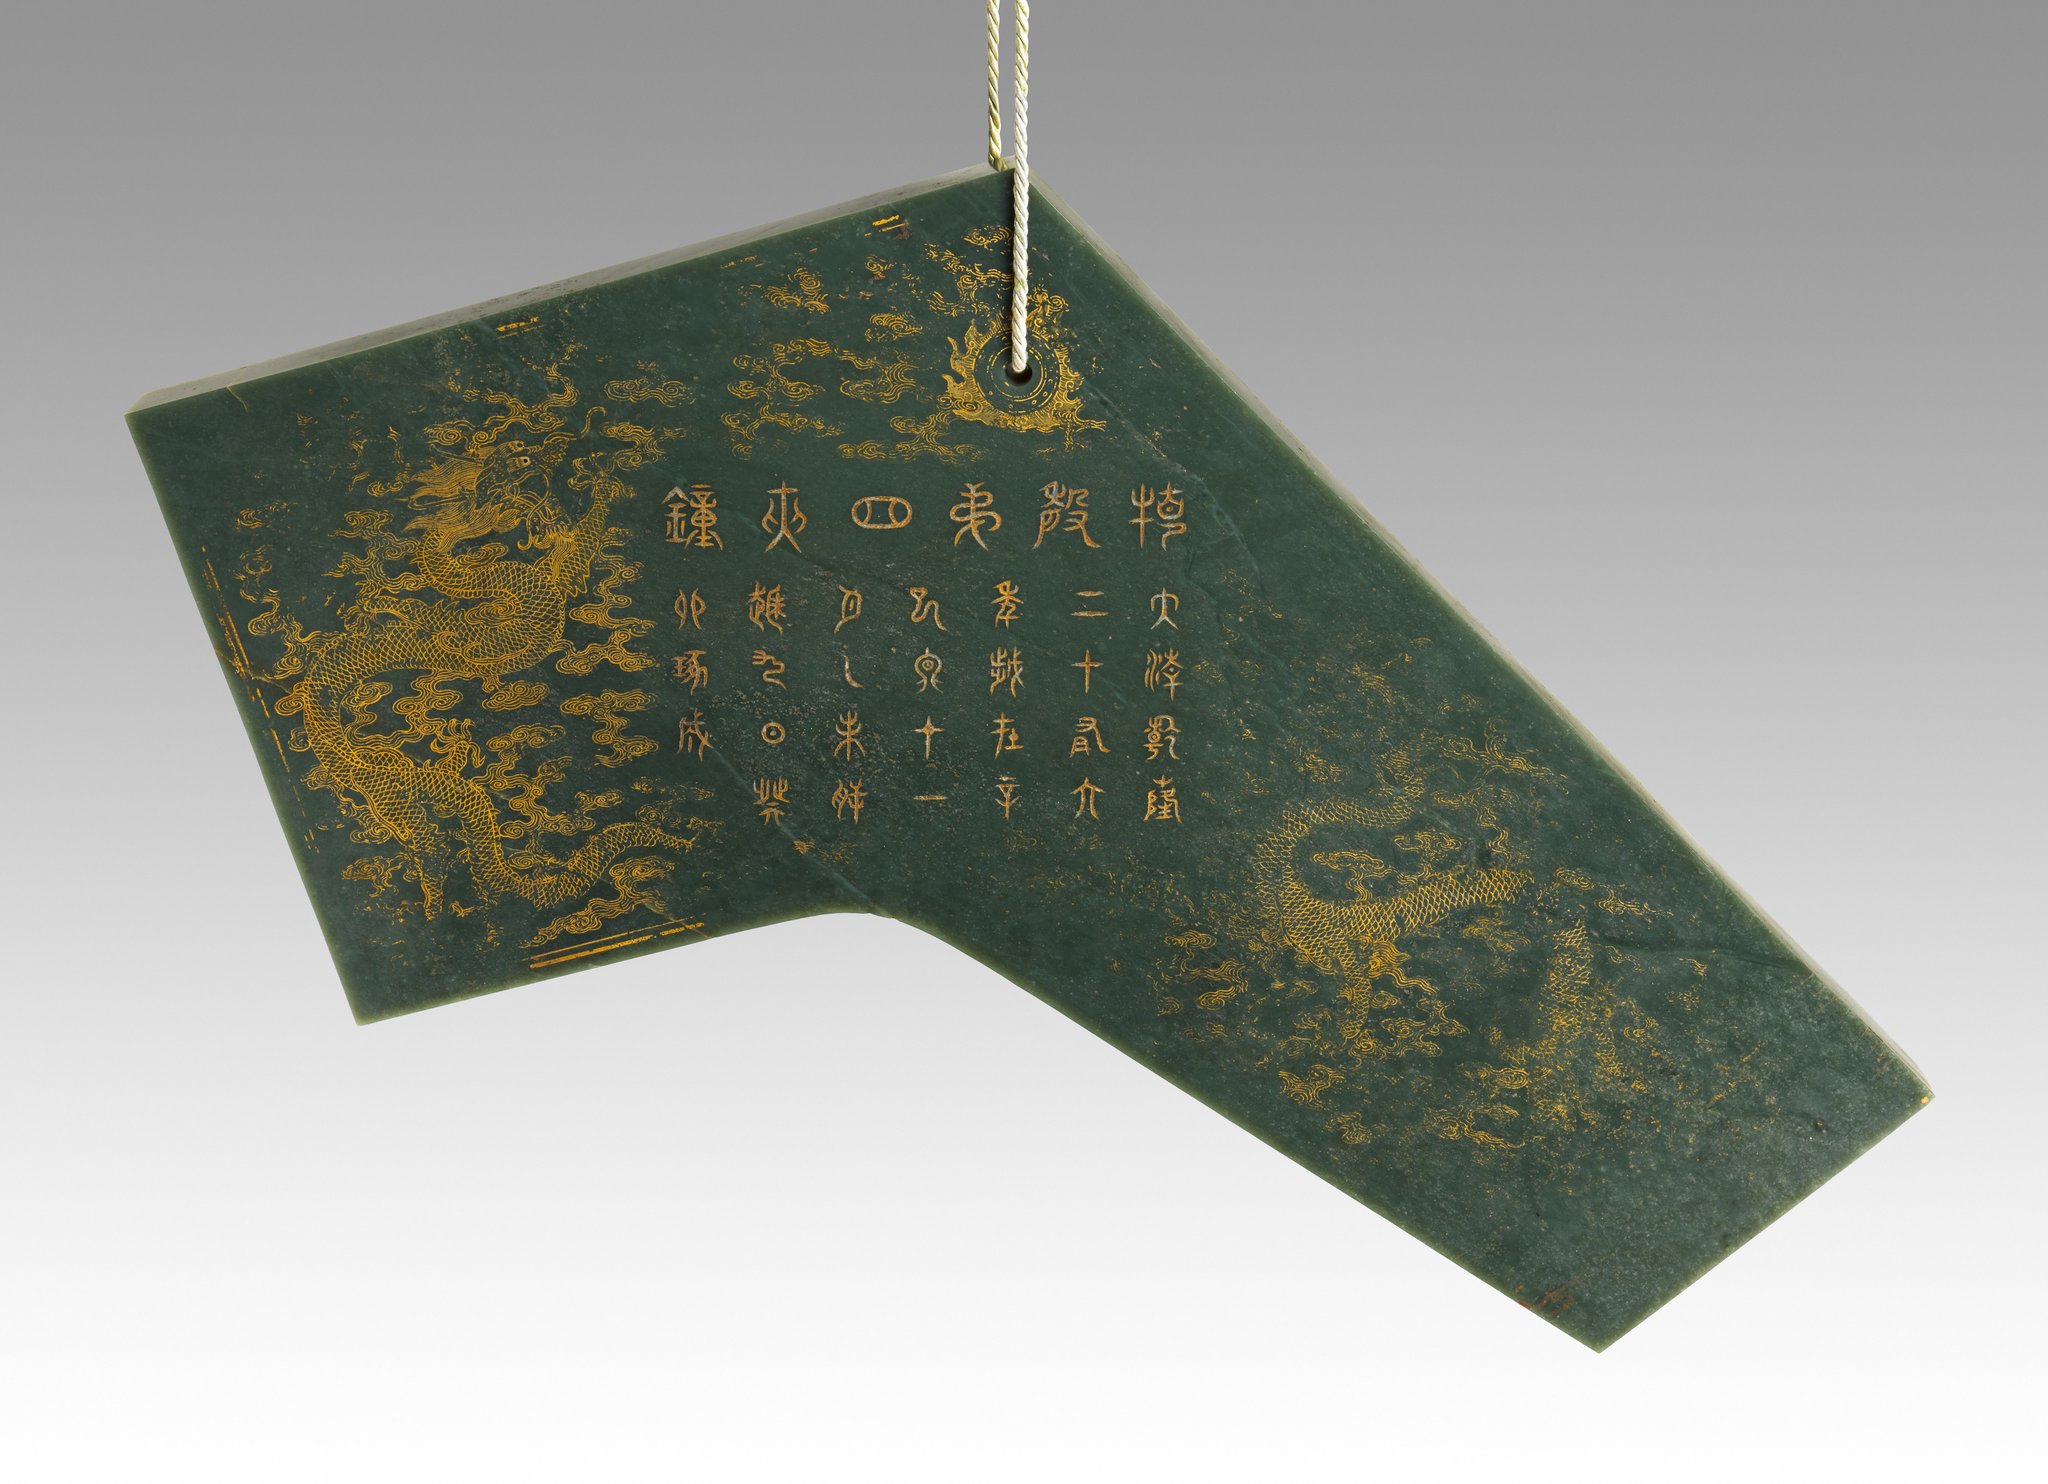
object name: chime qing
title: Qing (磬 )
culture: chinese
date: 1734-1766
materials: jade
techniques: gilding, incising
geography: china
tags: dragons